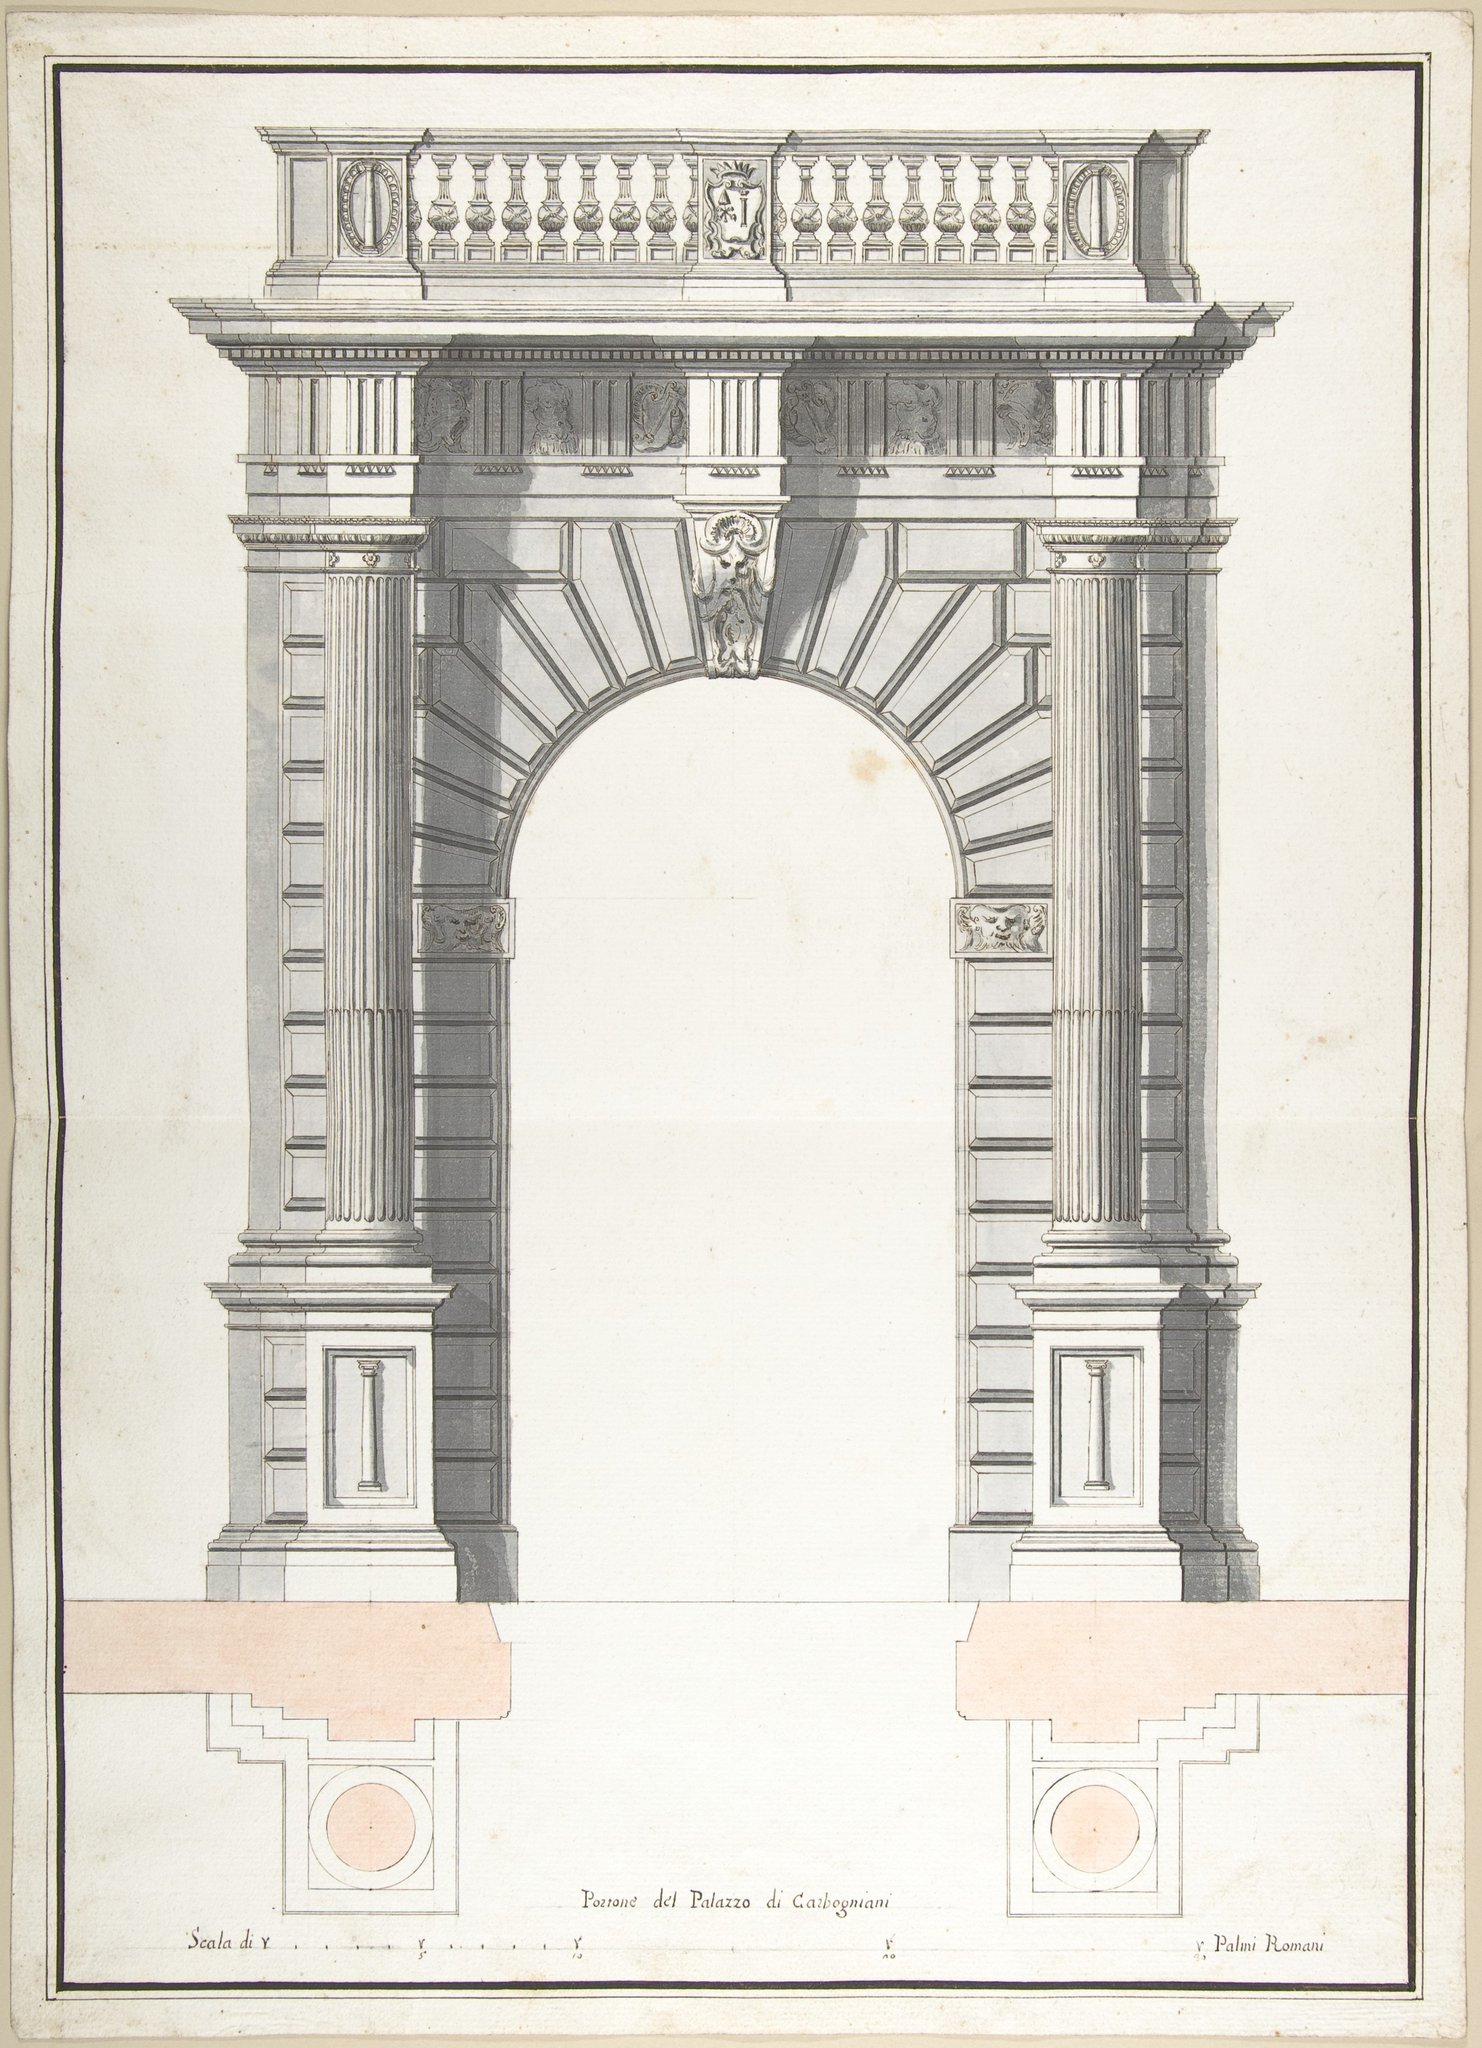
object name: drawing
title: Portone del Palazzo di Carbogniani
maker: pietro paolo coccetti (cocchetti)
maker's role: artist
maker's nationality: italian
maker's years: 1710-1727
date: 1710-1727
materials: graphite, ink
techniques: brush, pen, wash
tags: architecture,arches,columns